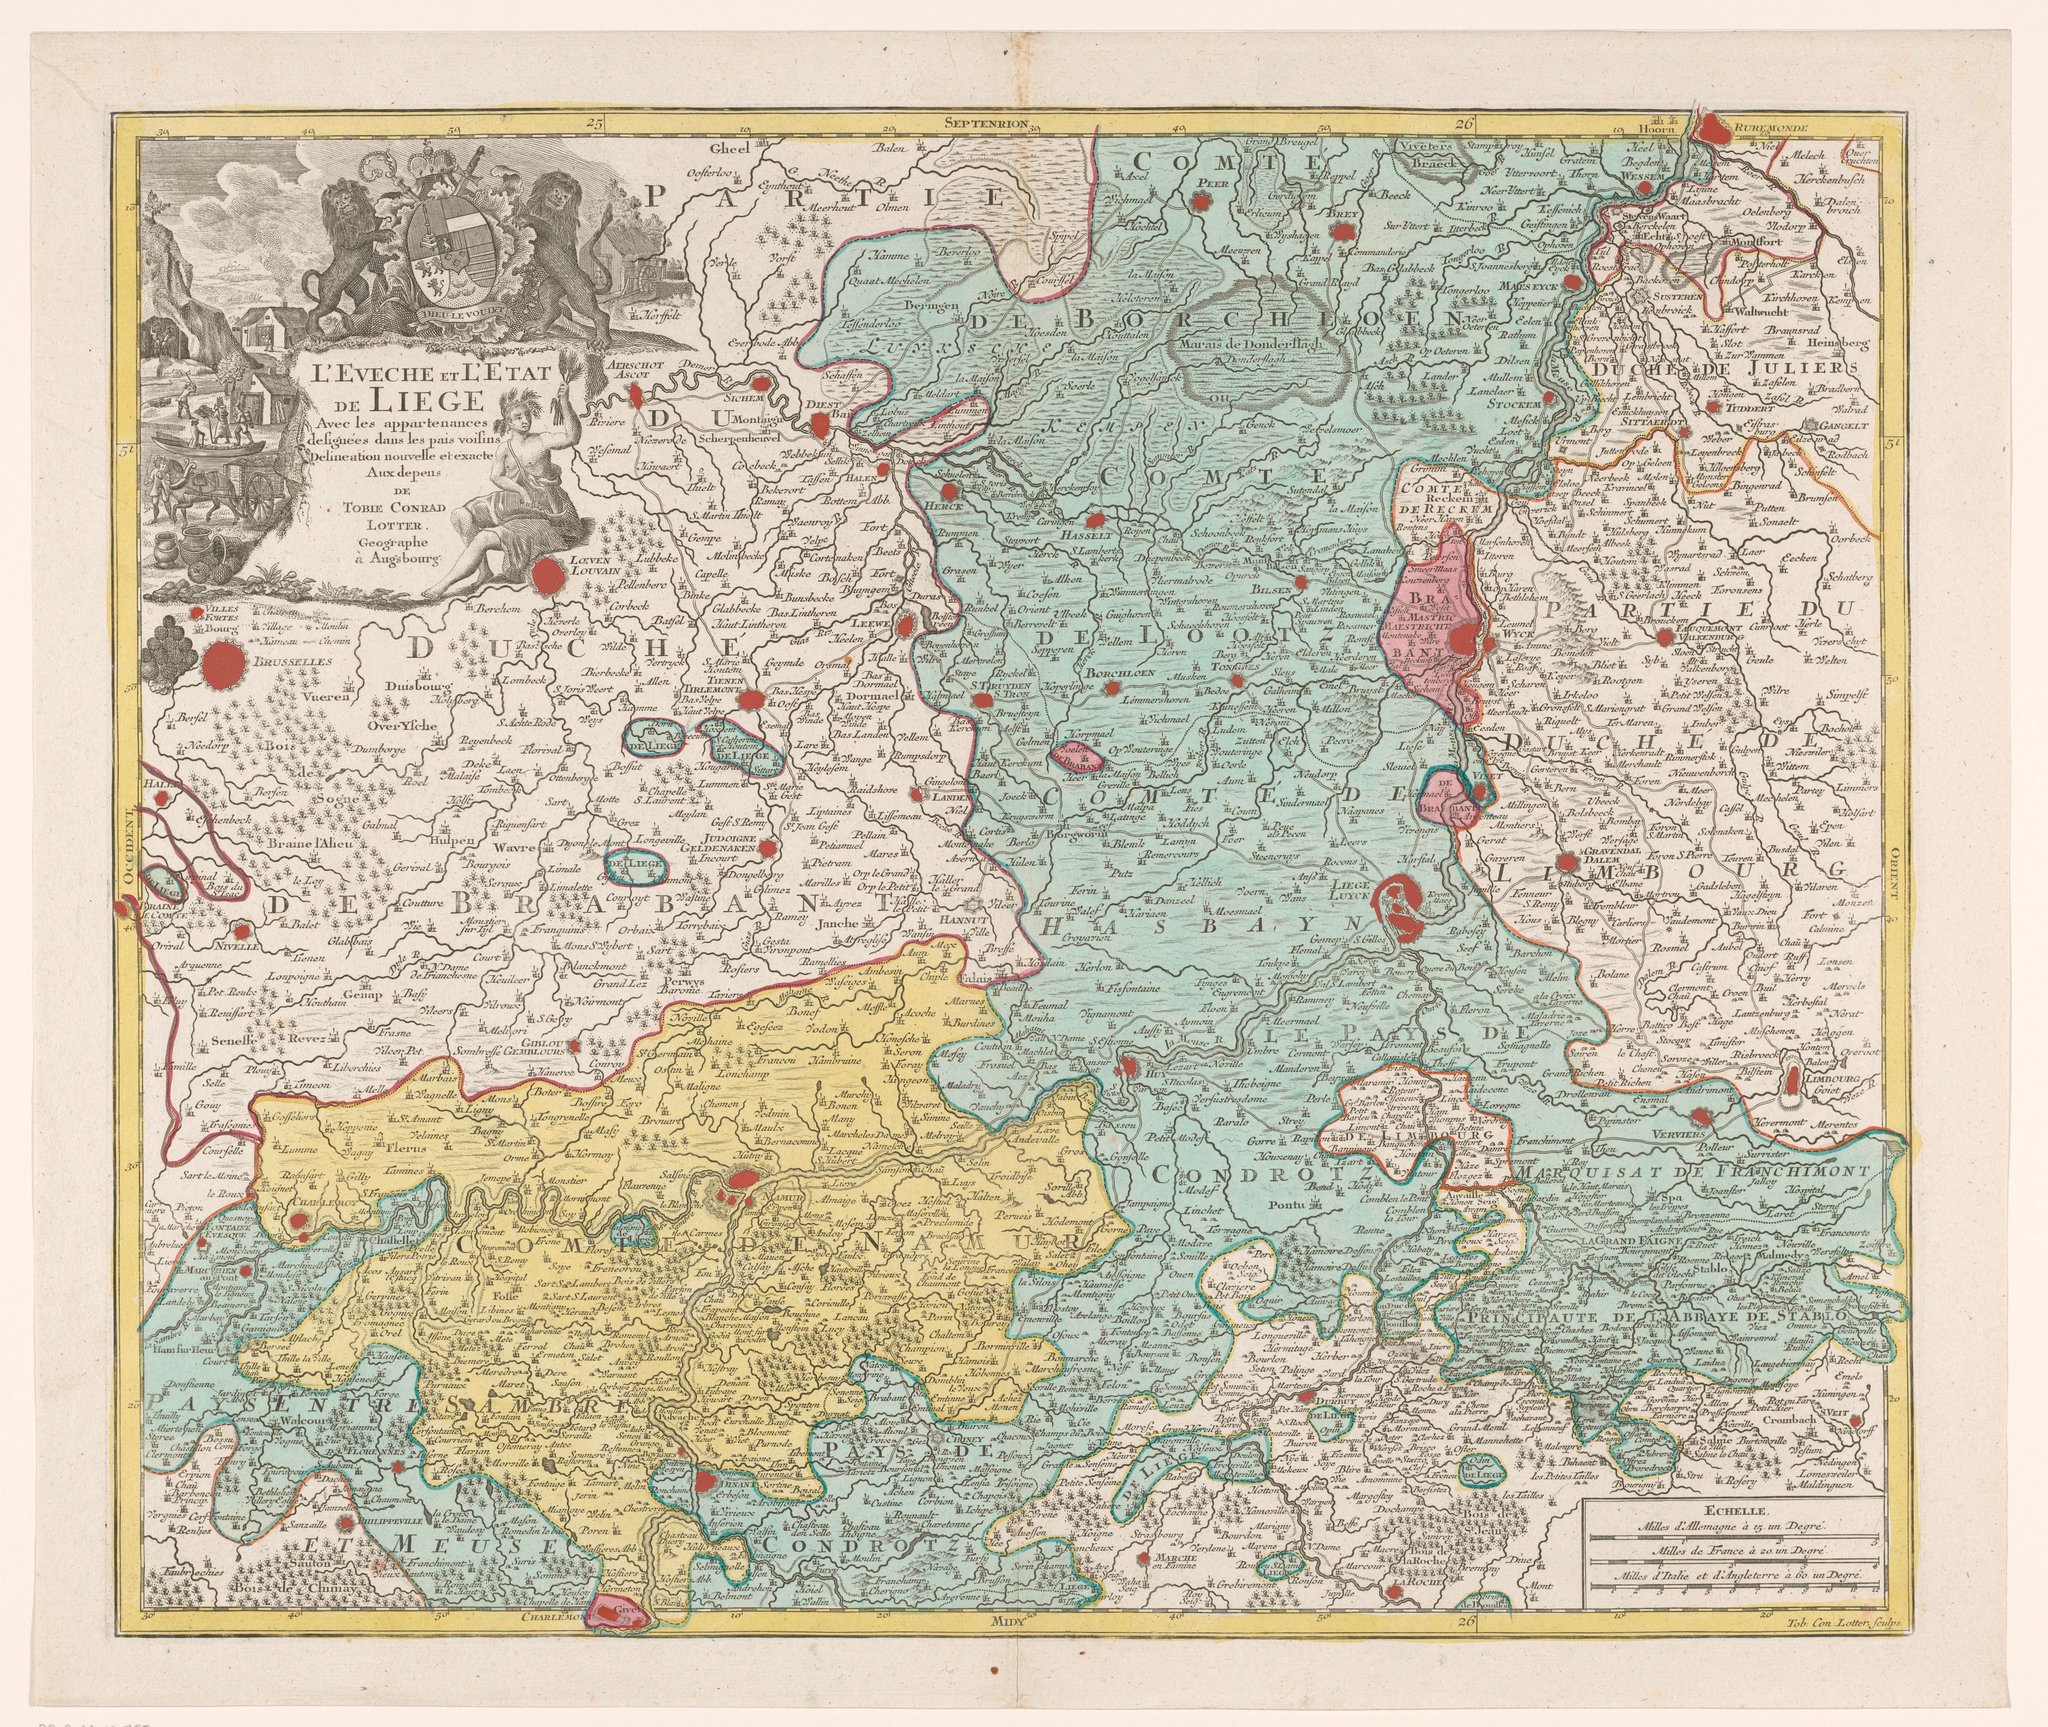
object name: map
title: Kaart van het Prinsbisdom Luik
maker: tobias conrad lotter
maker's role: publisher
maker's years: 1717-1777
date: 1757-1777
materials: paper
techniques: engraving, hand coloring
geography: augsburg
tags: maps of separate countries or regions, coat of arms (as symbol of the state, etc.) (+ province; provincial), prince-bishopric of liège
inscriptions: collector's mark: Lugt 2228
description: Kaart van het Prinsbisdom Luik. Linksboven de titelcartouche met bovenin het wapen van de provincie Luik. Rechtsonder een kader met drie schaalstokken: 3 Milles d'Allemagne à 15 un Degré / 4 Milles de France à 20 un Degré / 12 Milles d'Italie et d'Angleterre à 60 un Degré. De kaart is voorzien van een gradenverdeling langs de randen.